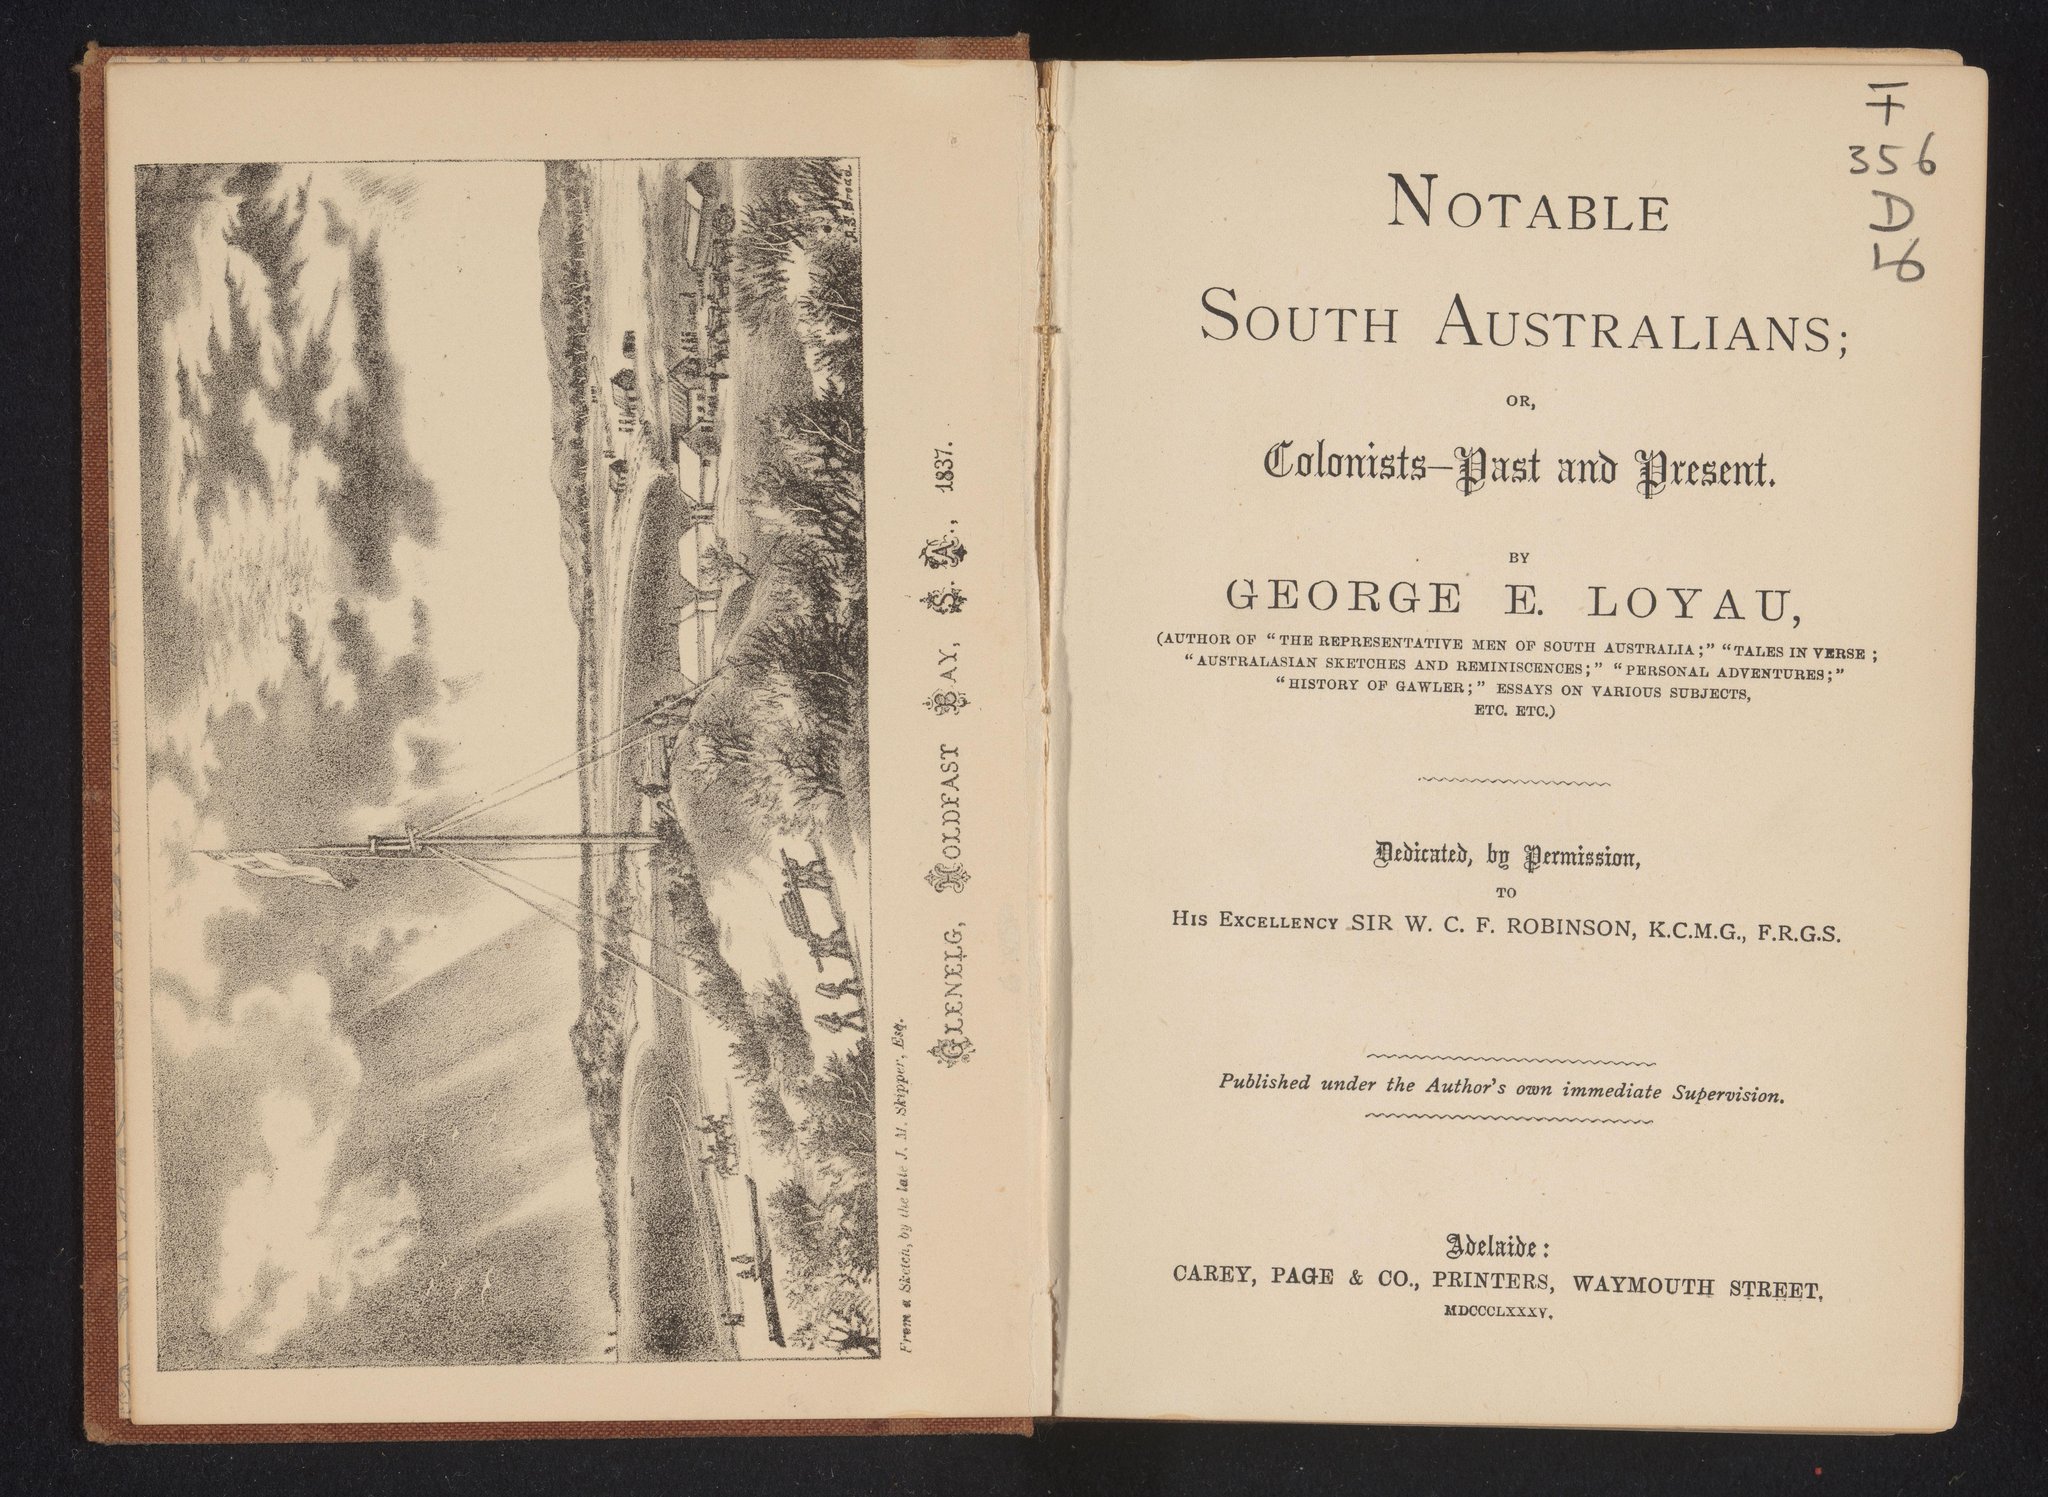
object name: book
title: Notable South Australians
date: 1885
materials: cardboard, linen, paper, photographic support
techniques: albumen print, lithograph, printing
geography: adelaide